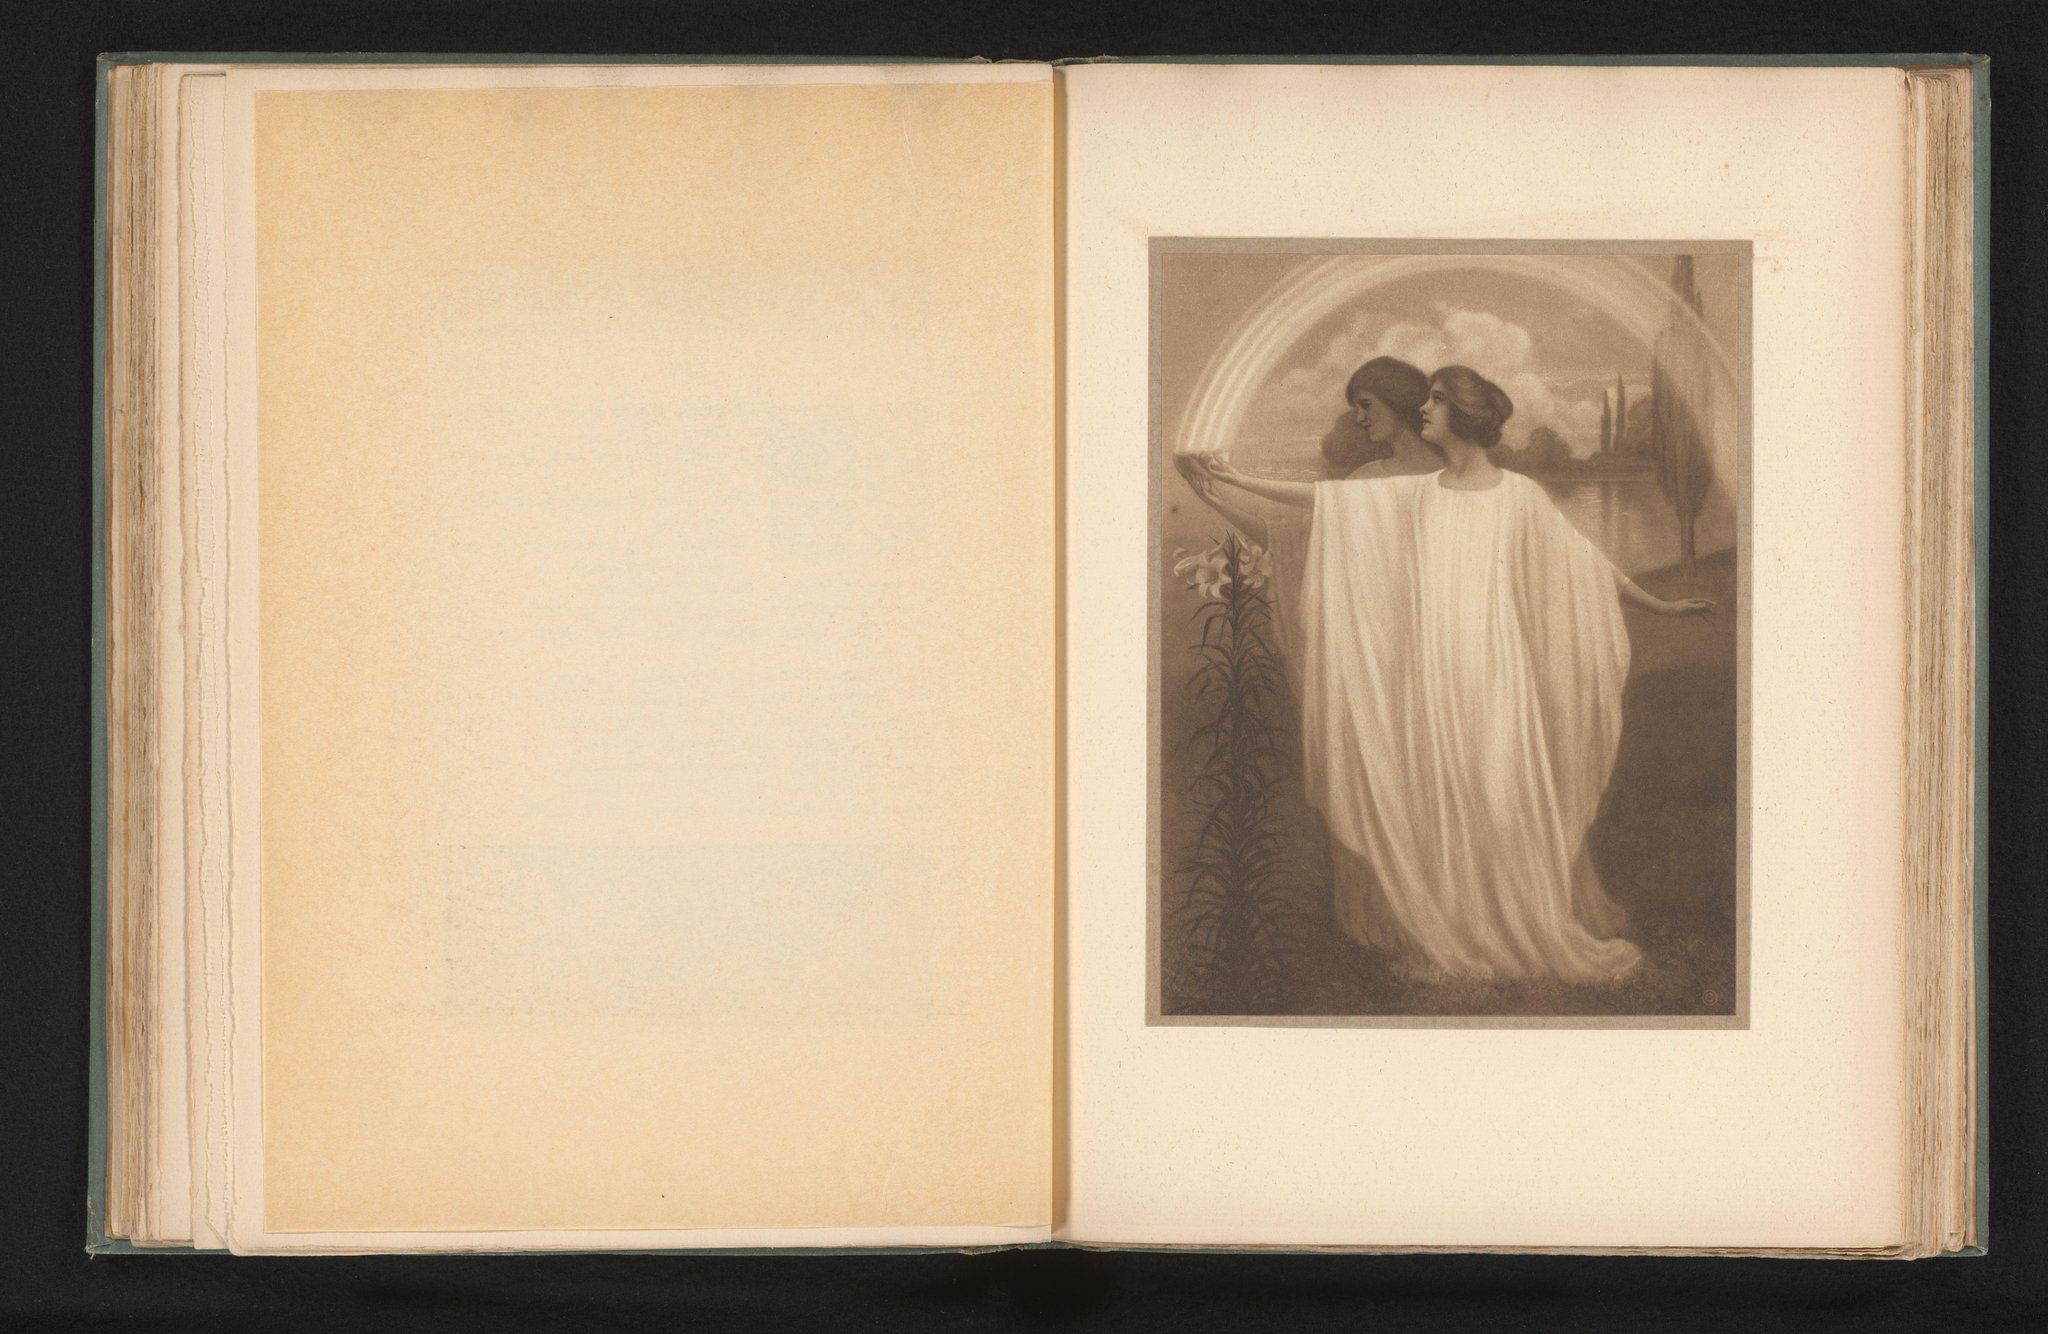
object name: photomechanical print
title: Twee vrouwen in een landschap met lelie en regenboog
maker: adelaide hanscom leeson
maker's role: painter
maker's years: 1875-1931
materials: cardboard, paper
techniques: photoaquatint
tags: adult woman (+ two persons), rainbow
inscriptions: copyright notice: ‘C’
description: Prent op ongenummerde pagina. Adelaide Hanscom Leeson manipuleerde haar glasnegatieven om een schilderachtig efffect te bewerkstelligen.